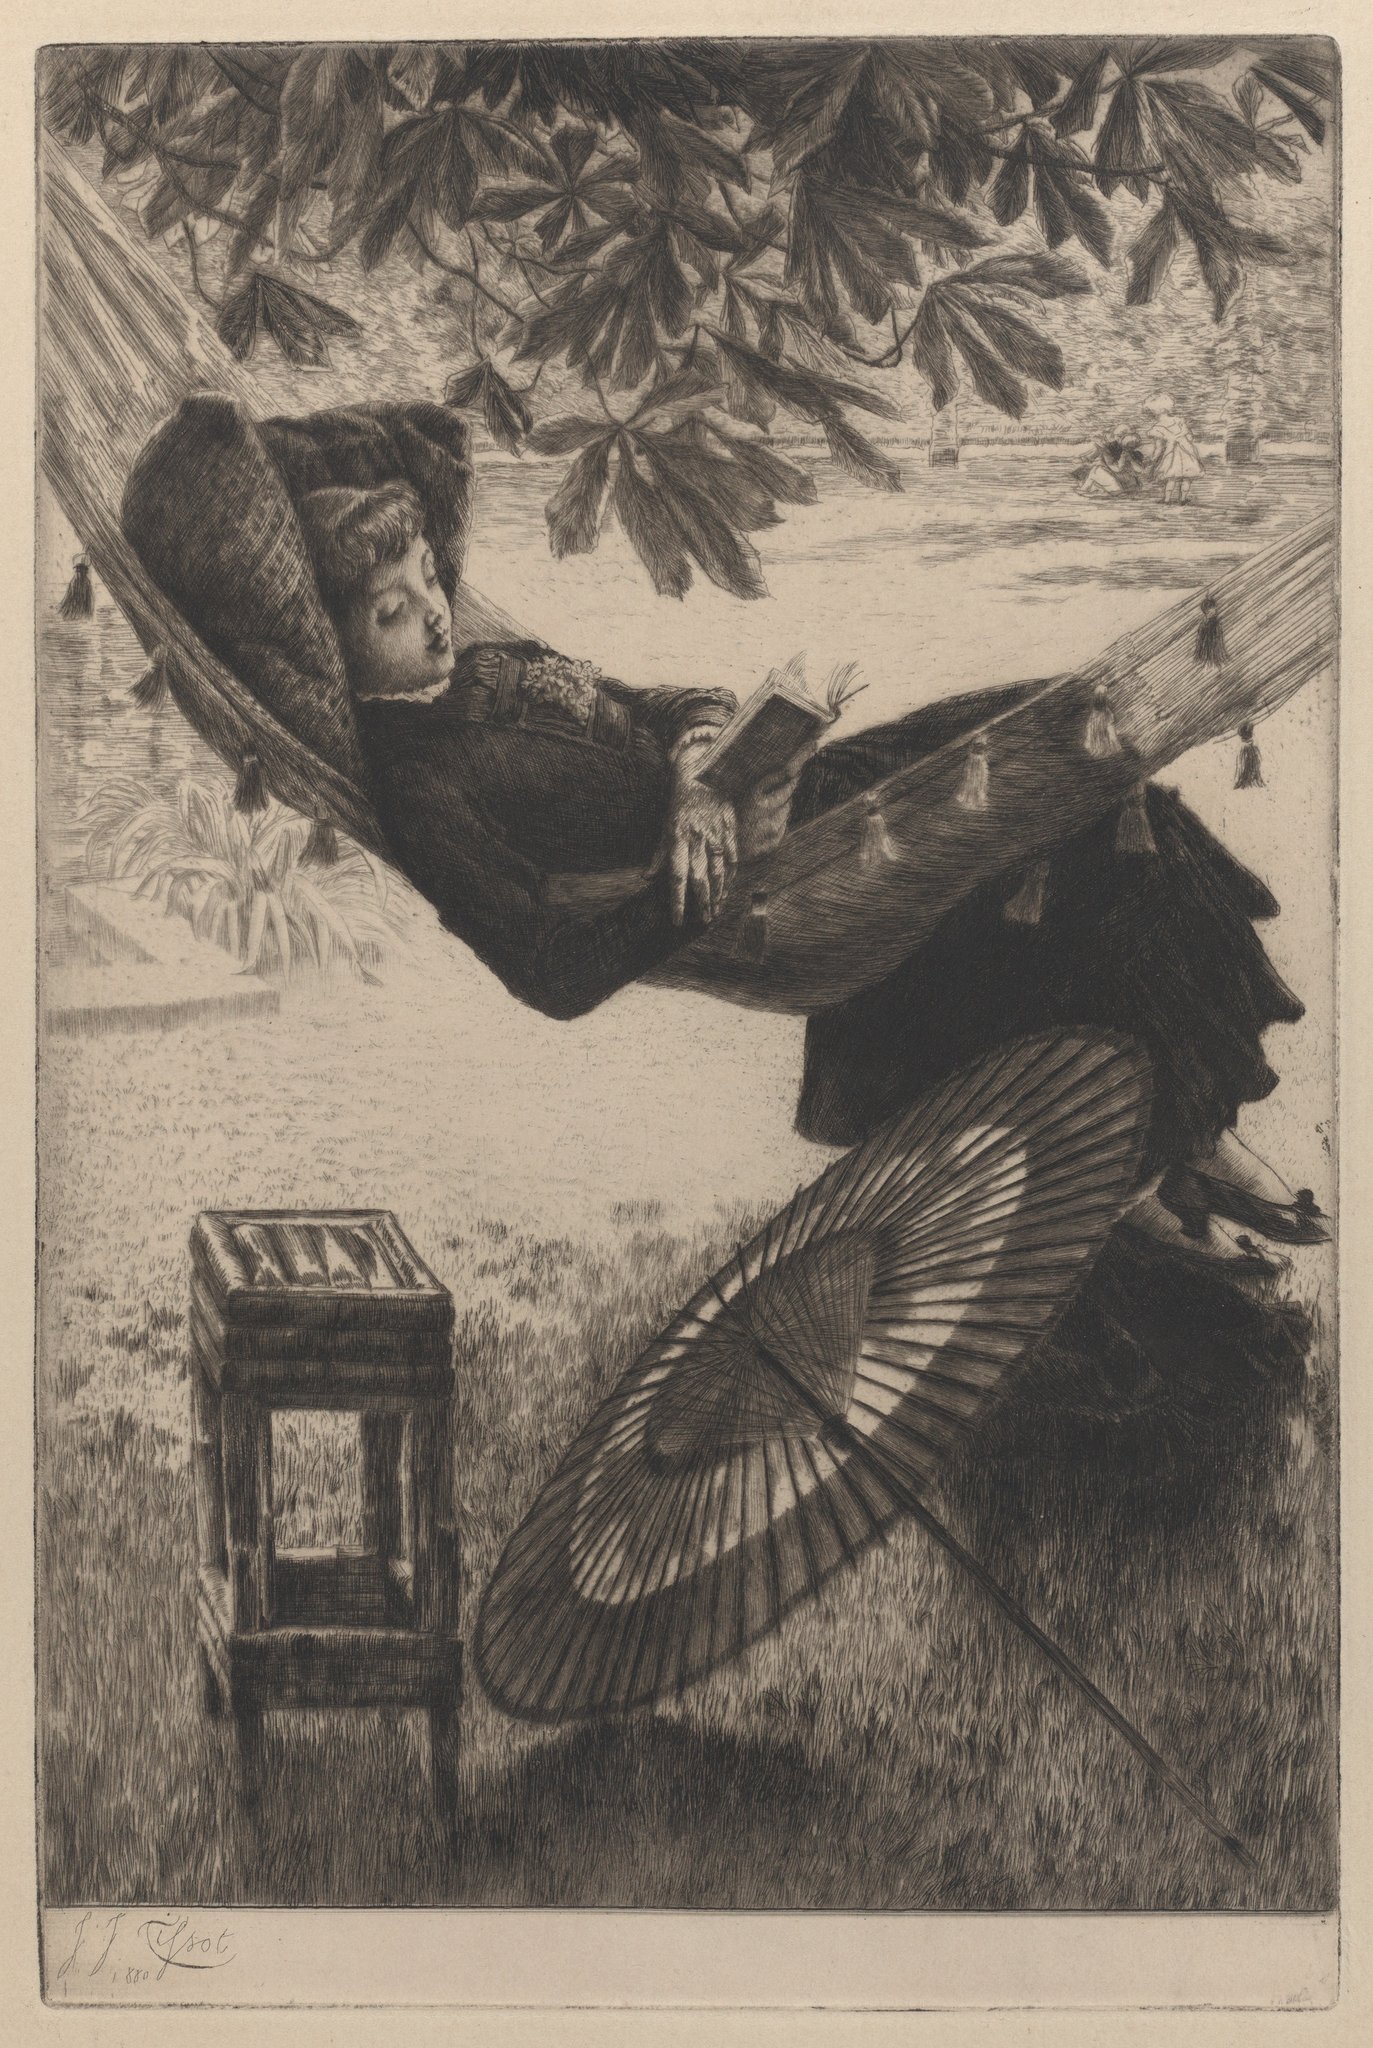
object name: print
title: The Hammock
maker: james tissot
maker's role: artist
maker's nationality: french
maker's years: 1836-1902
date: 1880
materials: paper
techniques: drypoint, etching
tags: women,reading,parasols